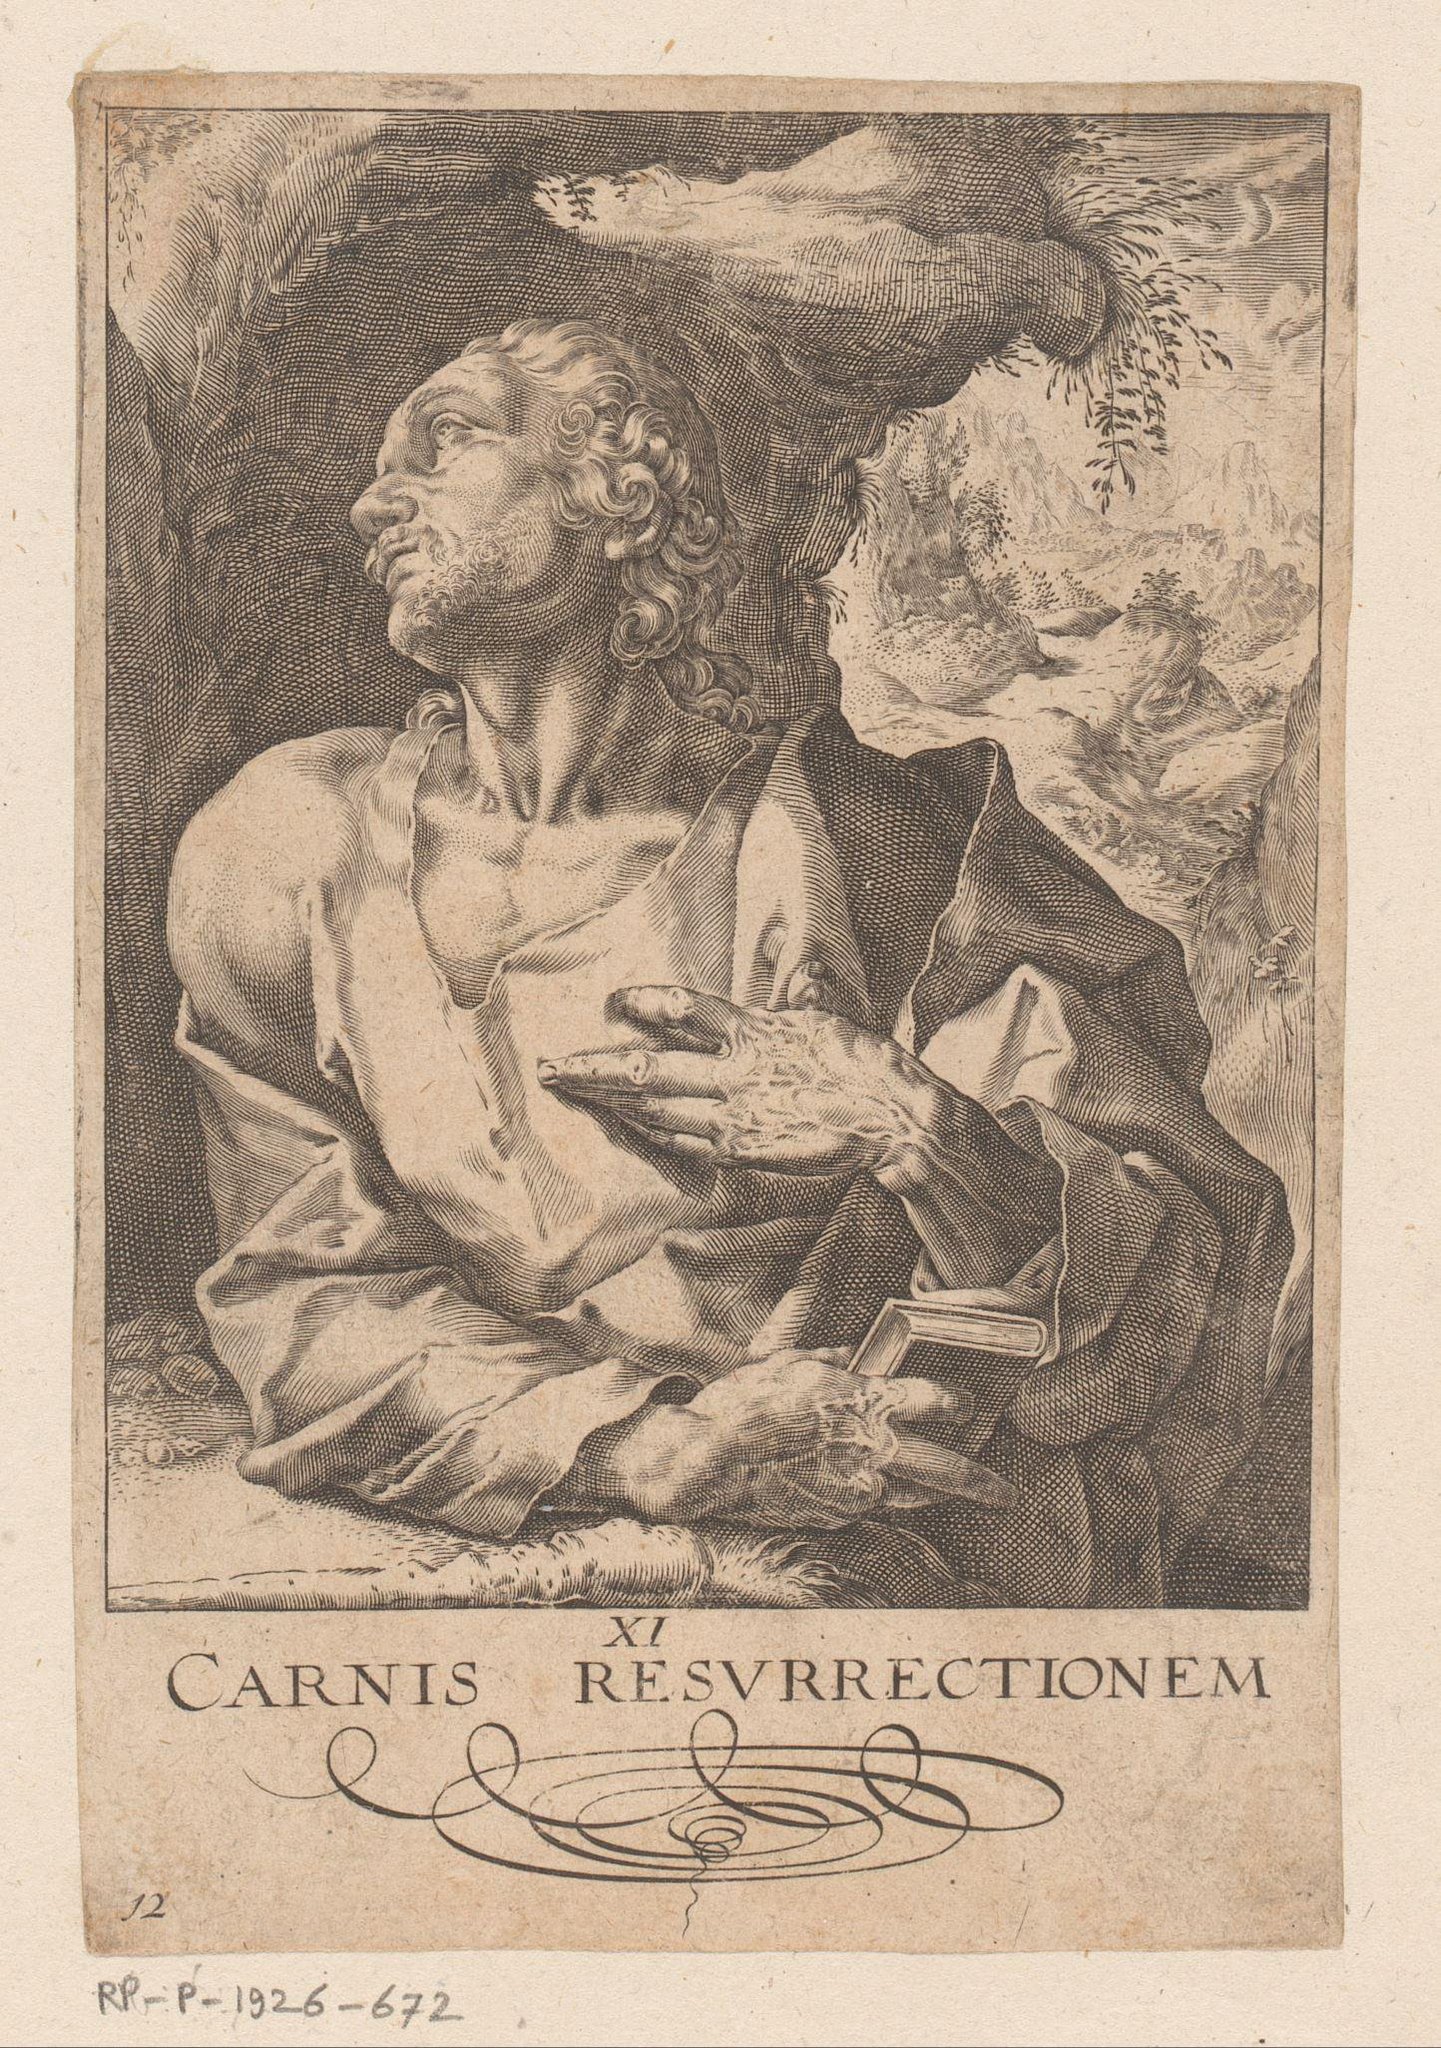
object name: print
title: Christus en de twaalf apostelen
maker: jacques granthomme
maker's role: print maker, publisher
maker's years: 1550-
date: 1588-1622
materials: paper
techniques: engraving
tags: the apostle jude thaddaeus; possible attributes: book, club, halberd, scroll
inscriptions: collector's mark: Lugt 1432, collector's mark: Lugt 2166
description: Maakt deel uit van een dertiendelige serie van Christus en de twaalf apostelen naar Hendrick Goltzius.